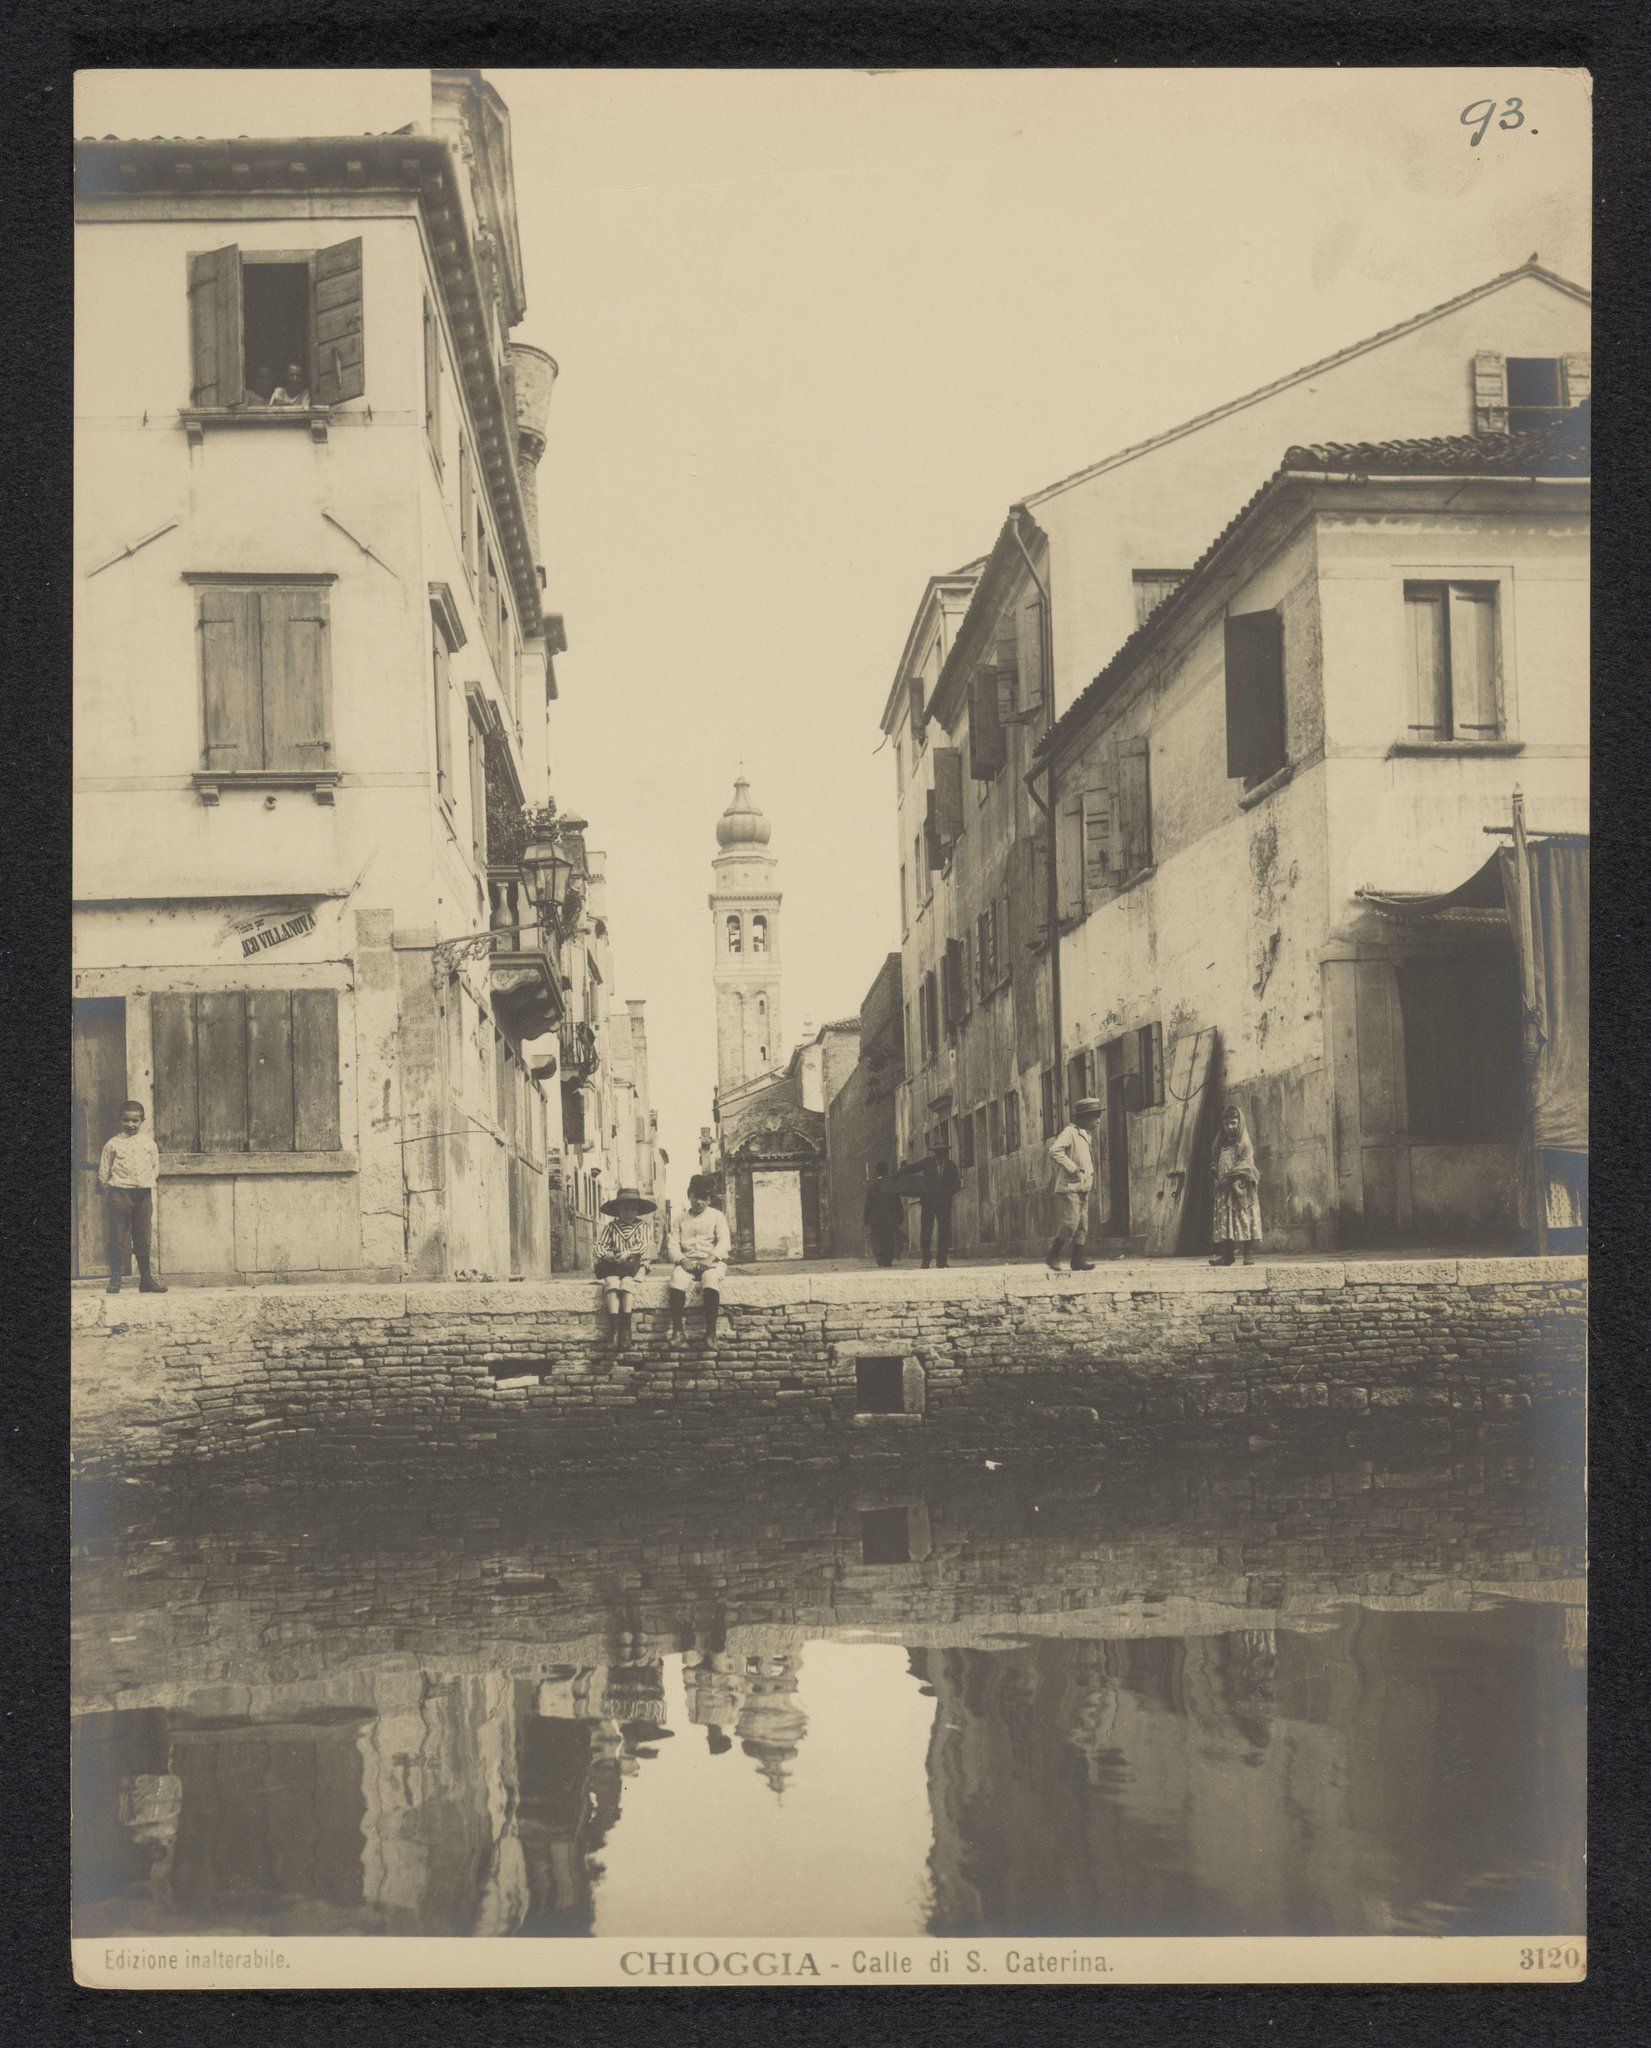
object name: photograph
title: Chioggia - Calle di S. Caterina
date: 1900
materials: cardboard, photographic support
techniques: gelatin silver print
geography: chioggia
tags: canal, quay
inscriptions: number: ‘3120.’, number: ‘93.’